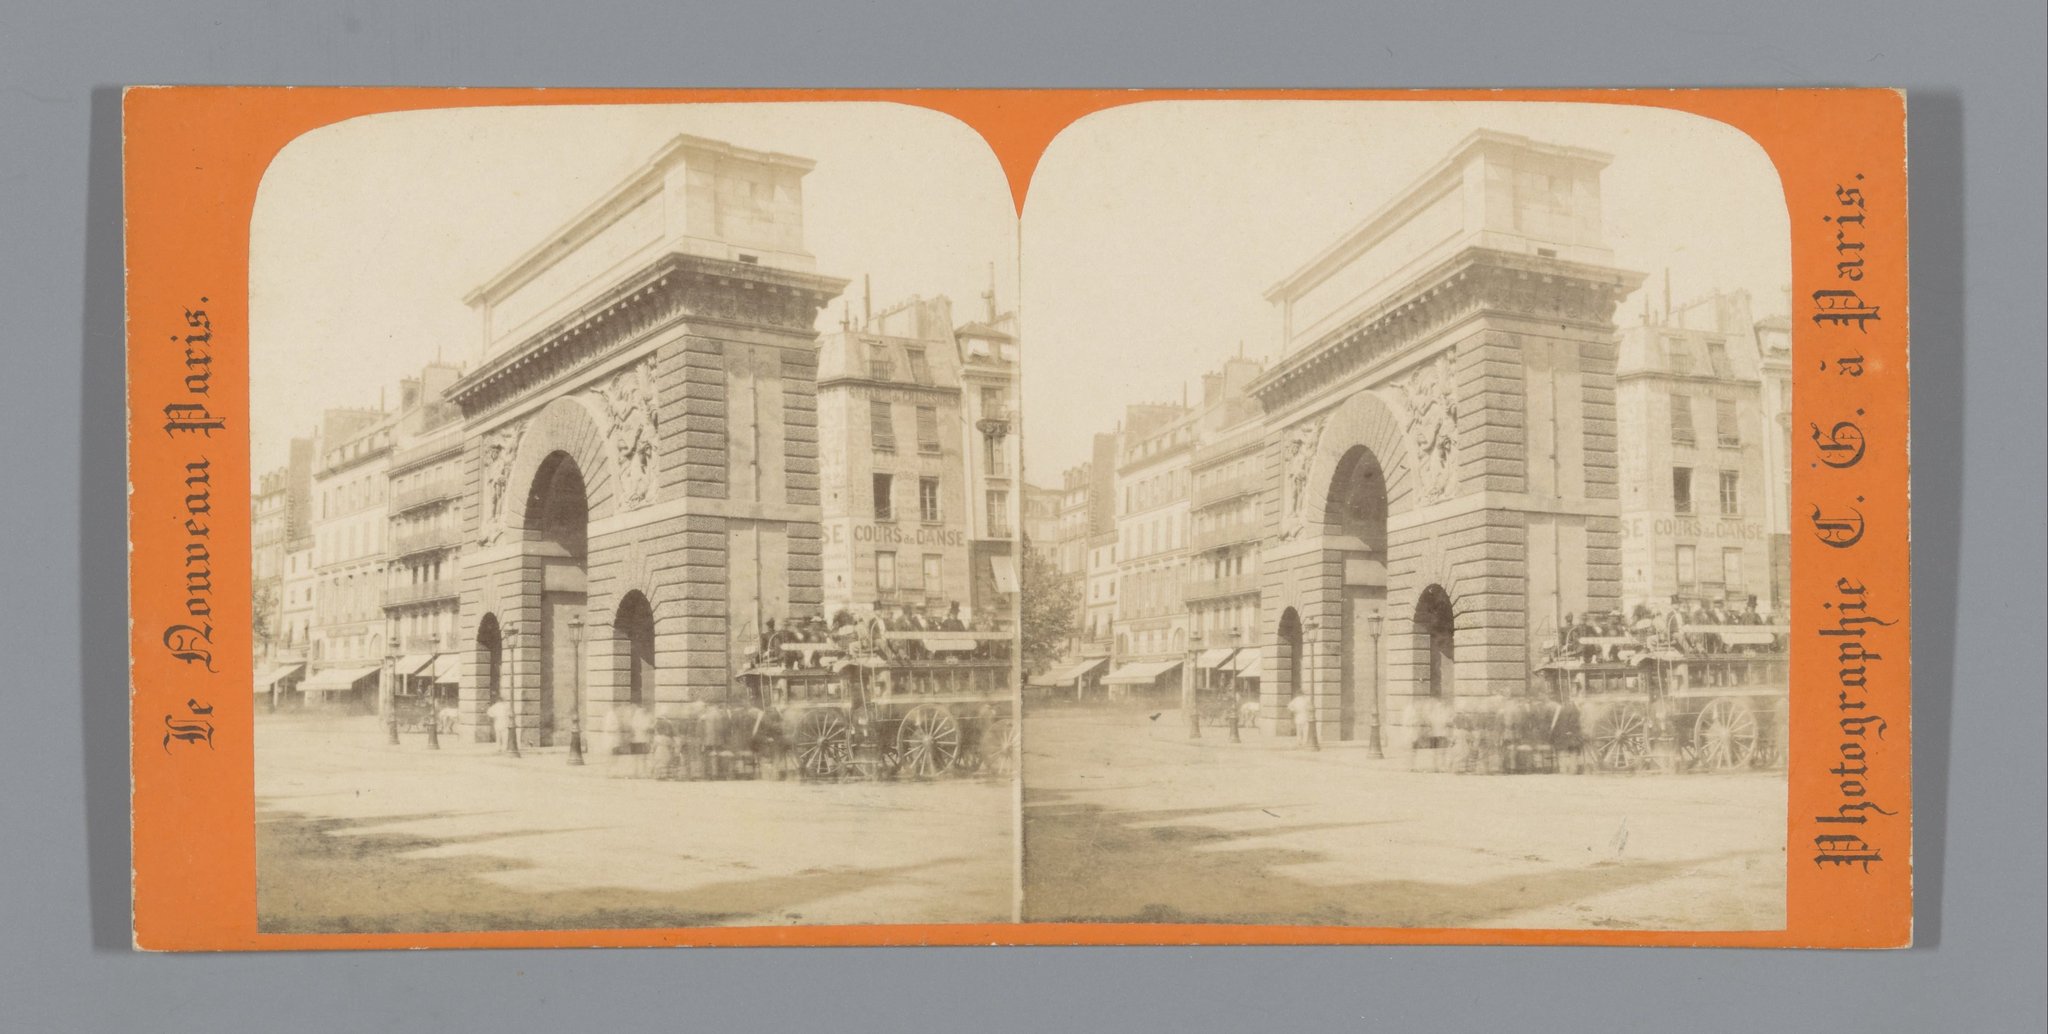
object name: stereograph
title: Le Nouveau Paris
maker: charles gérard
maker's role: fotograaf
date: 1850-1875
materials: cardboard, photographic support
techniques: albumen print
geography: paris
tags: triumphal arch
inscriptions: inscription: ‘Porte St Martin’